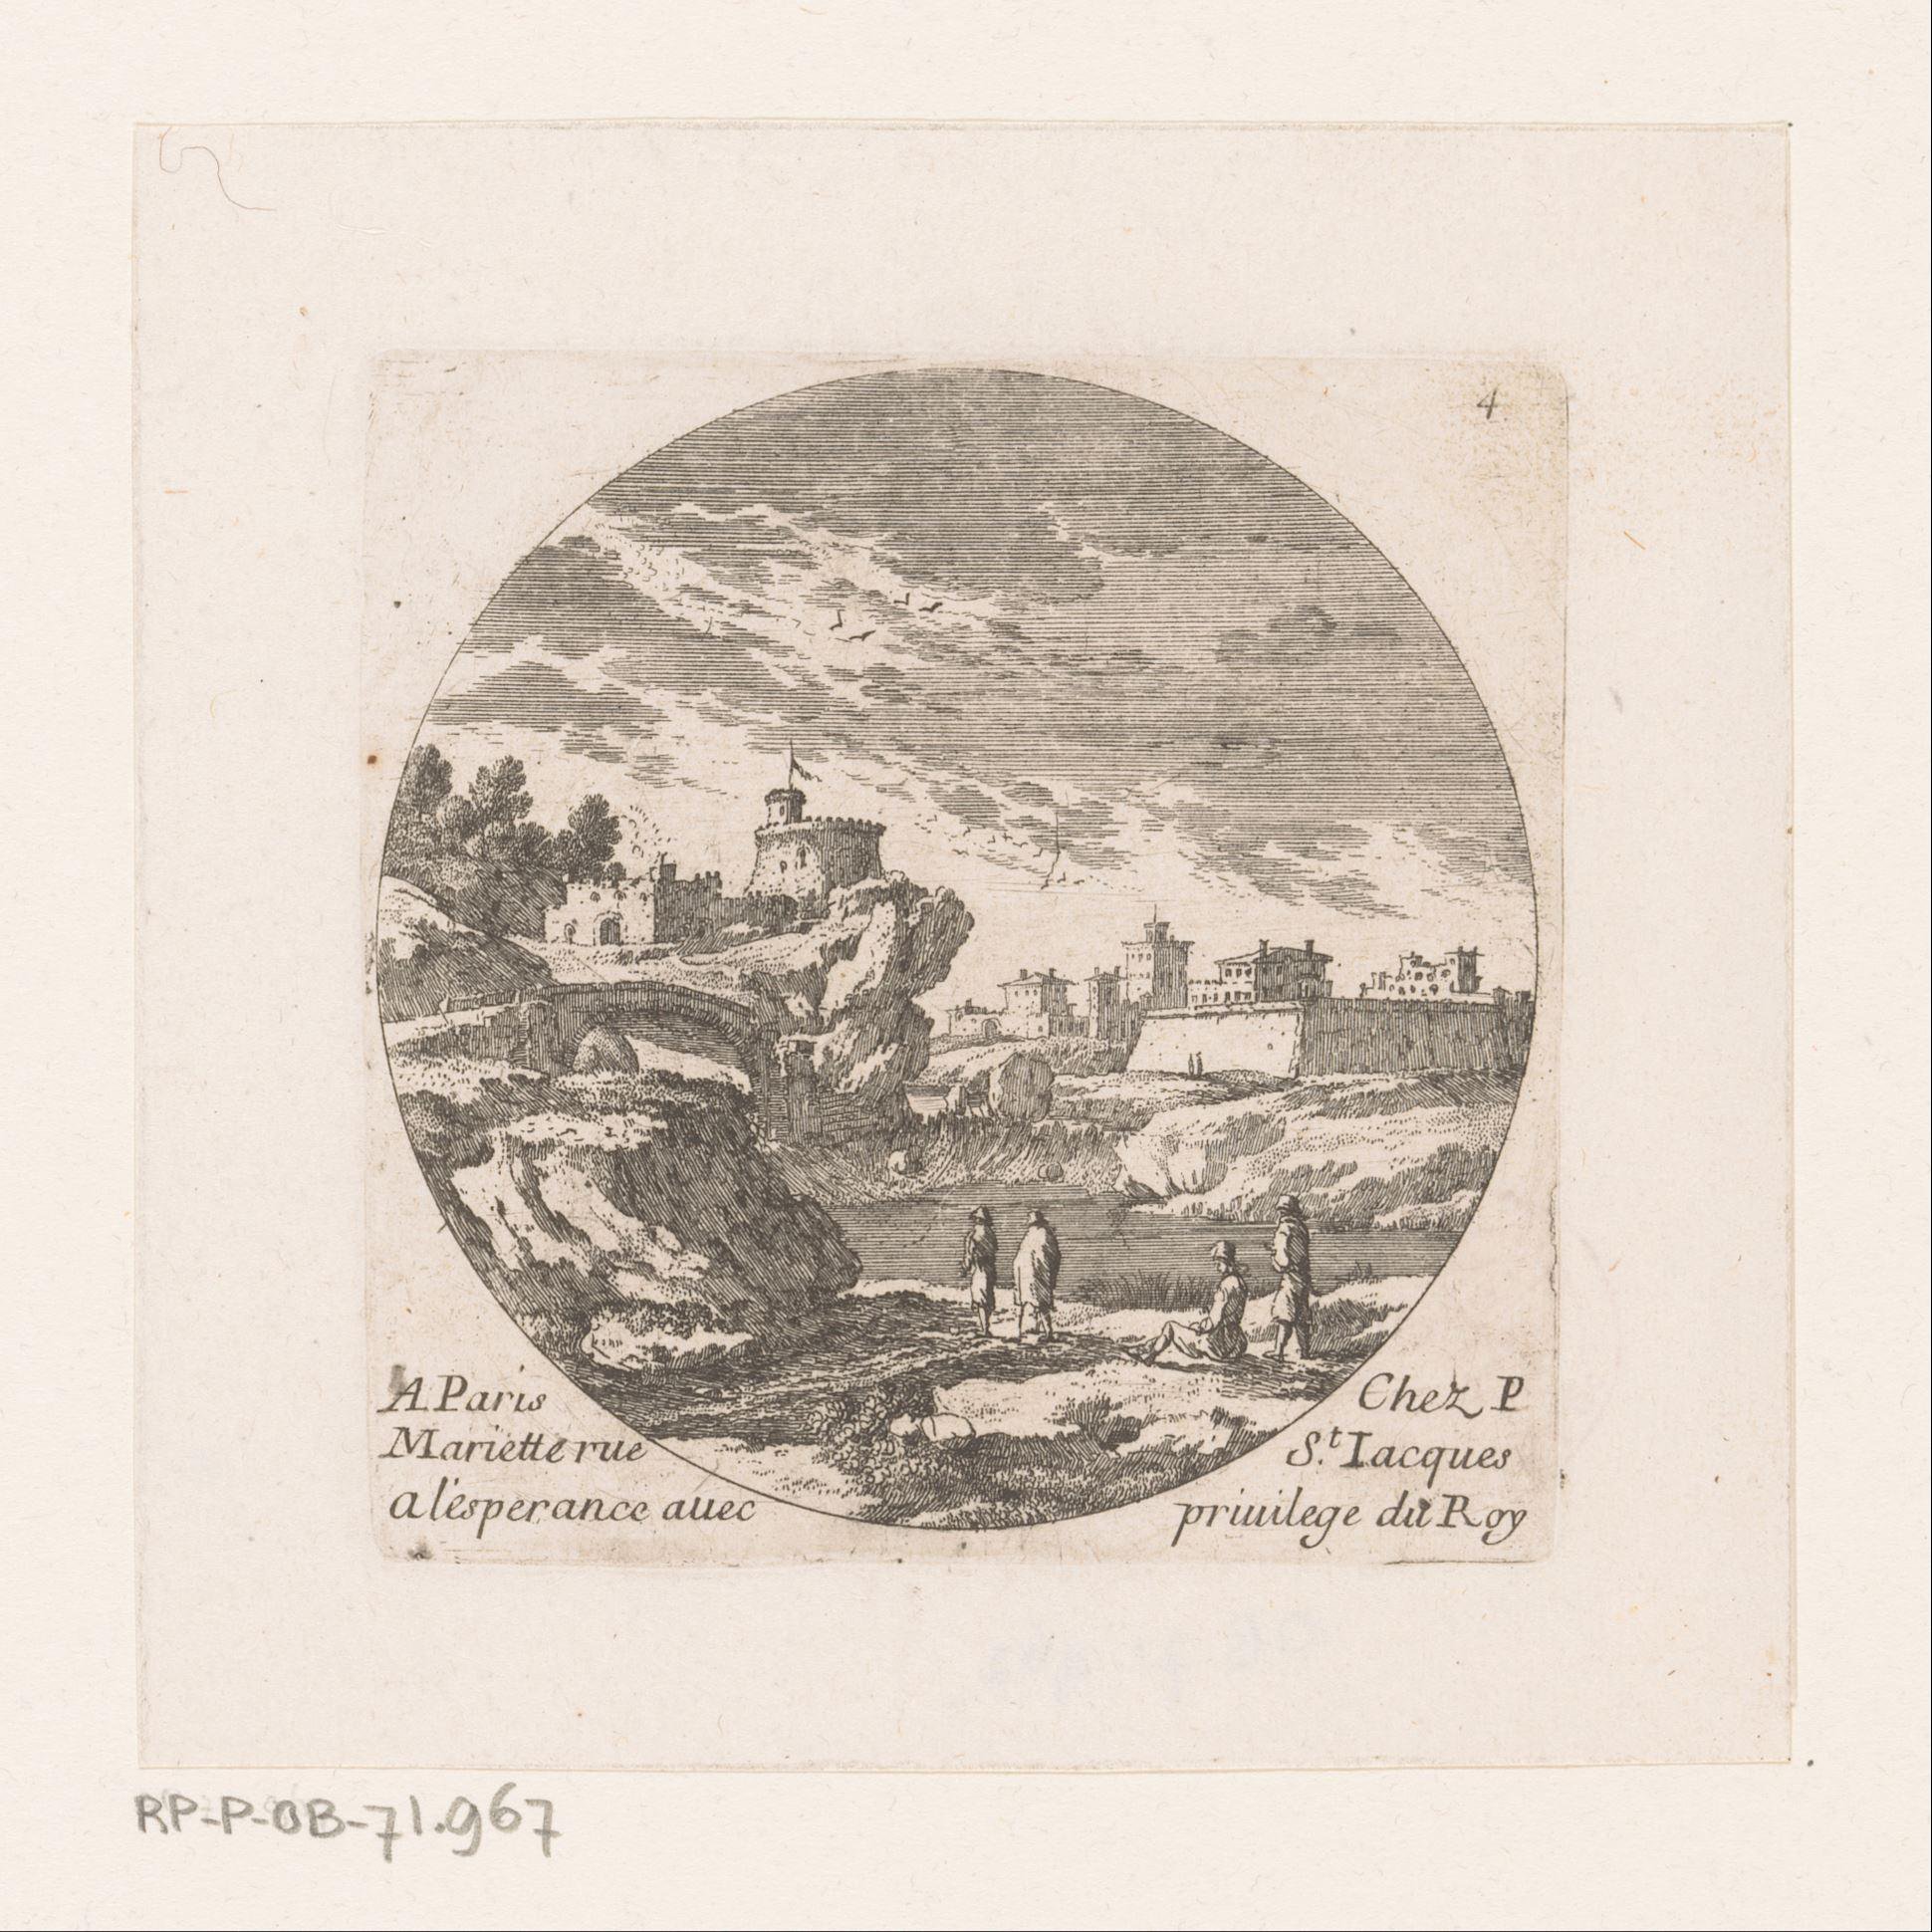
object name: print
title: Figuren bij water voor vestingstad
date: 1613-1695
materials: paper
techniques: etching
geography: france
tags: city-view in general; 'veduta', fortified city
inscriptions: collector's mark: Lugt 240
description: Prenten met het signatuur 'Perelle' kunnen zowel door vader Gabriel als door zonen Nicolas en Adam gemaakt zijn.